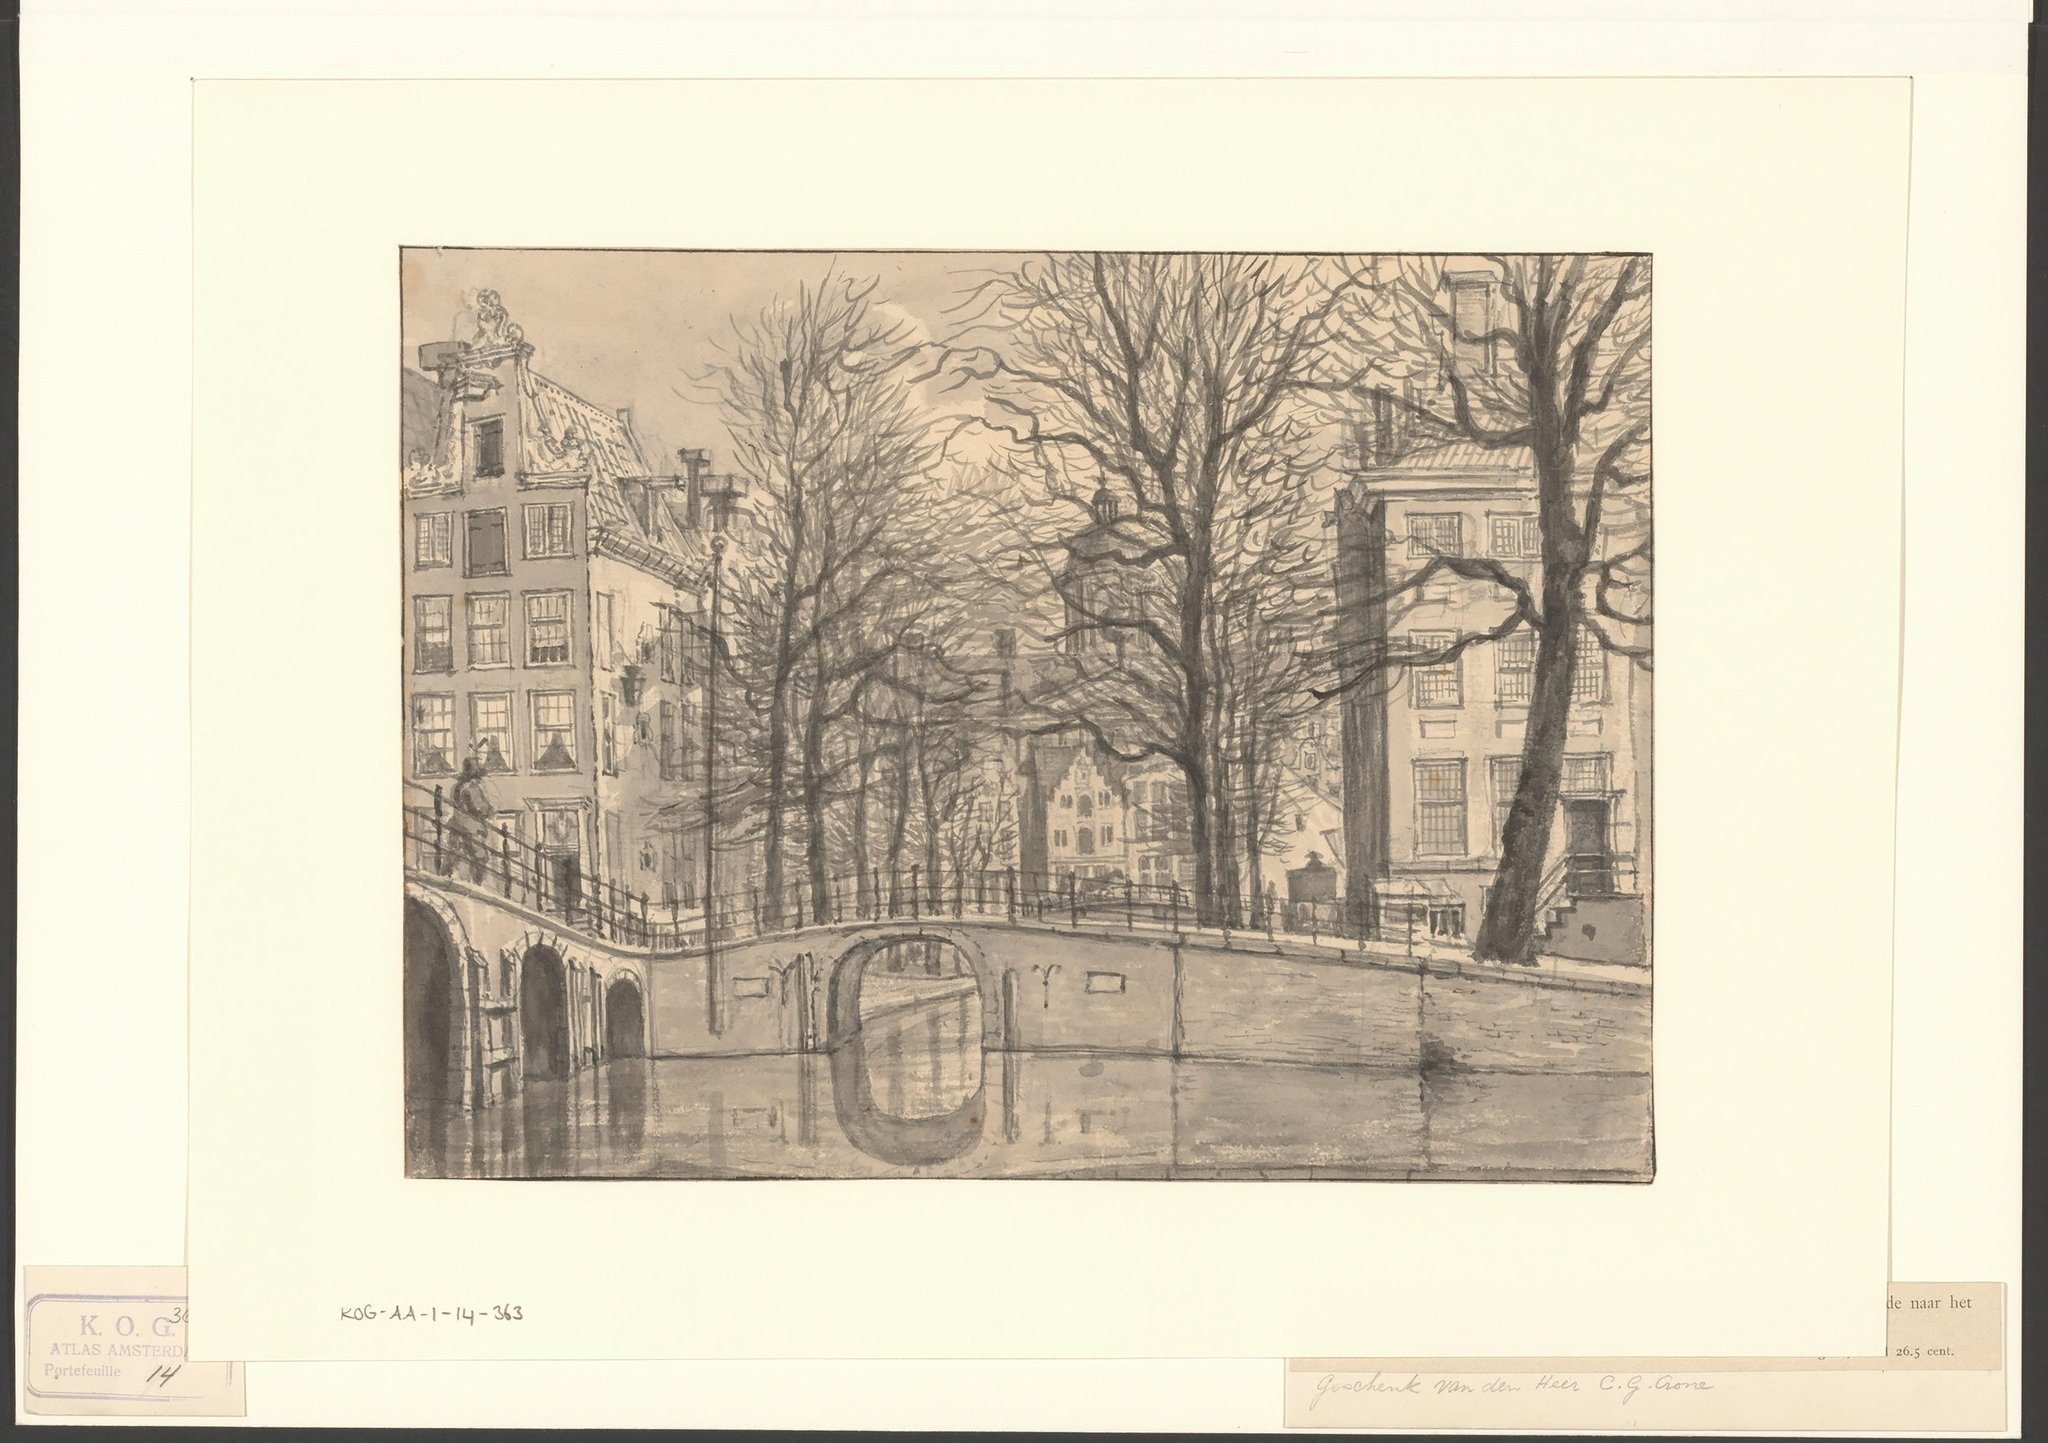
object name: drawing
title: Gezicht op de Warmoesgracht vanaf de Herengracht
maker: gerrit lamberts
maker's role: bookseller, draughtsman, print maker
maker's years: 1776-1850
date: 1786-1850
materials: chalk, ink, paper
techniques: brush, pen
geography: amsterdam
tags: city-view in general; 'veduta', canal, bridge in city across river, canal, etc.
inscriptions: inscription: ‘Port. 14-363’, inscription: ‘59 Gezicht op (...) Heer C.G. Crone’, collector's mark: ‘14’ Lugt 1641b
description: Onderwerpsrubriek binnen de Atlas Amsterdam: Waal (Kromme en Oude), Walenpleintje, Warmoesgracht, Warmoesstraat, Waterlooplein, Westerdoksdijk, Westermarkt, Weteringschans, Willemspark, Willemsstraat, Wittenburg, Wittenkade (de), Wittenstraat (de).